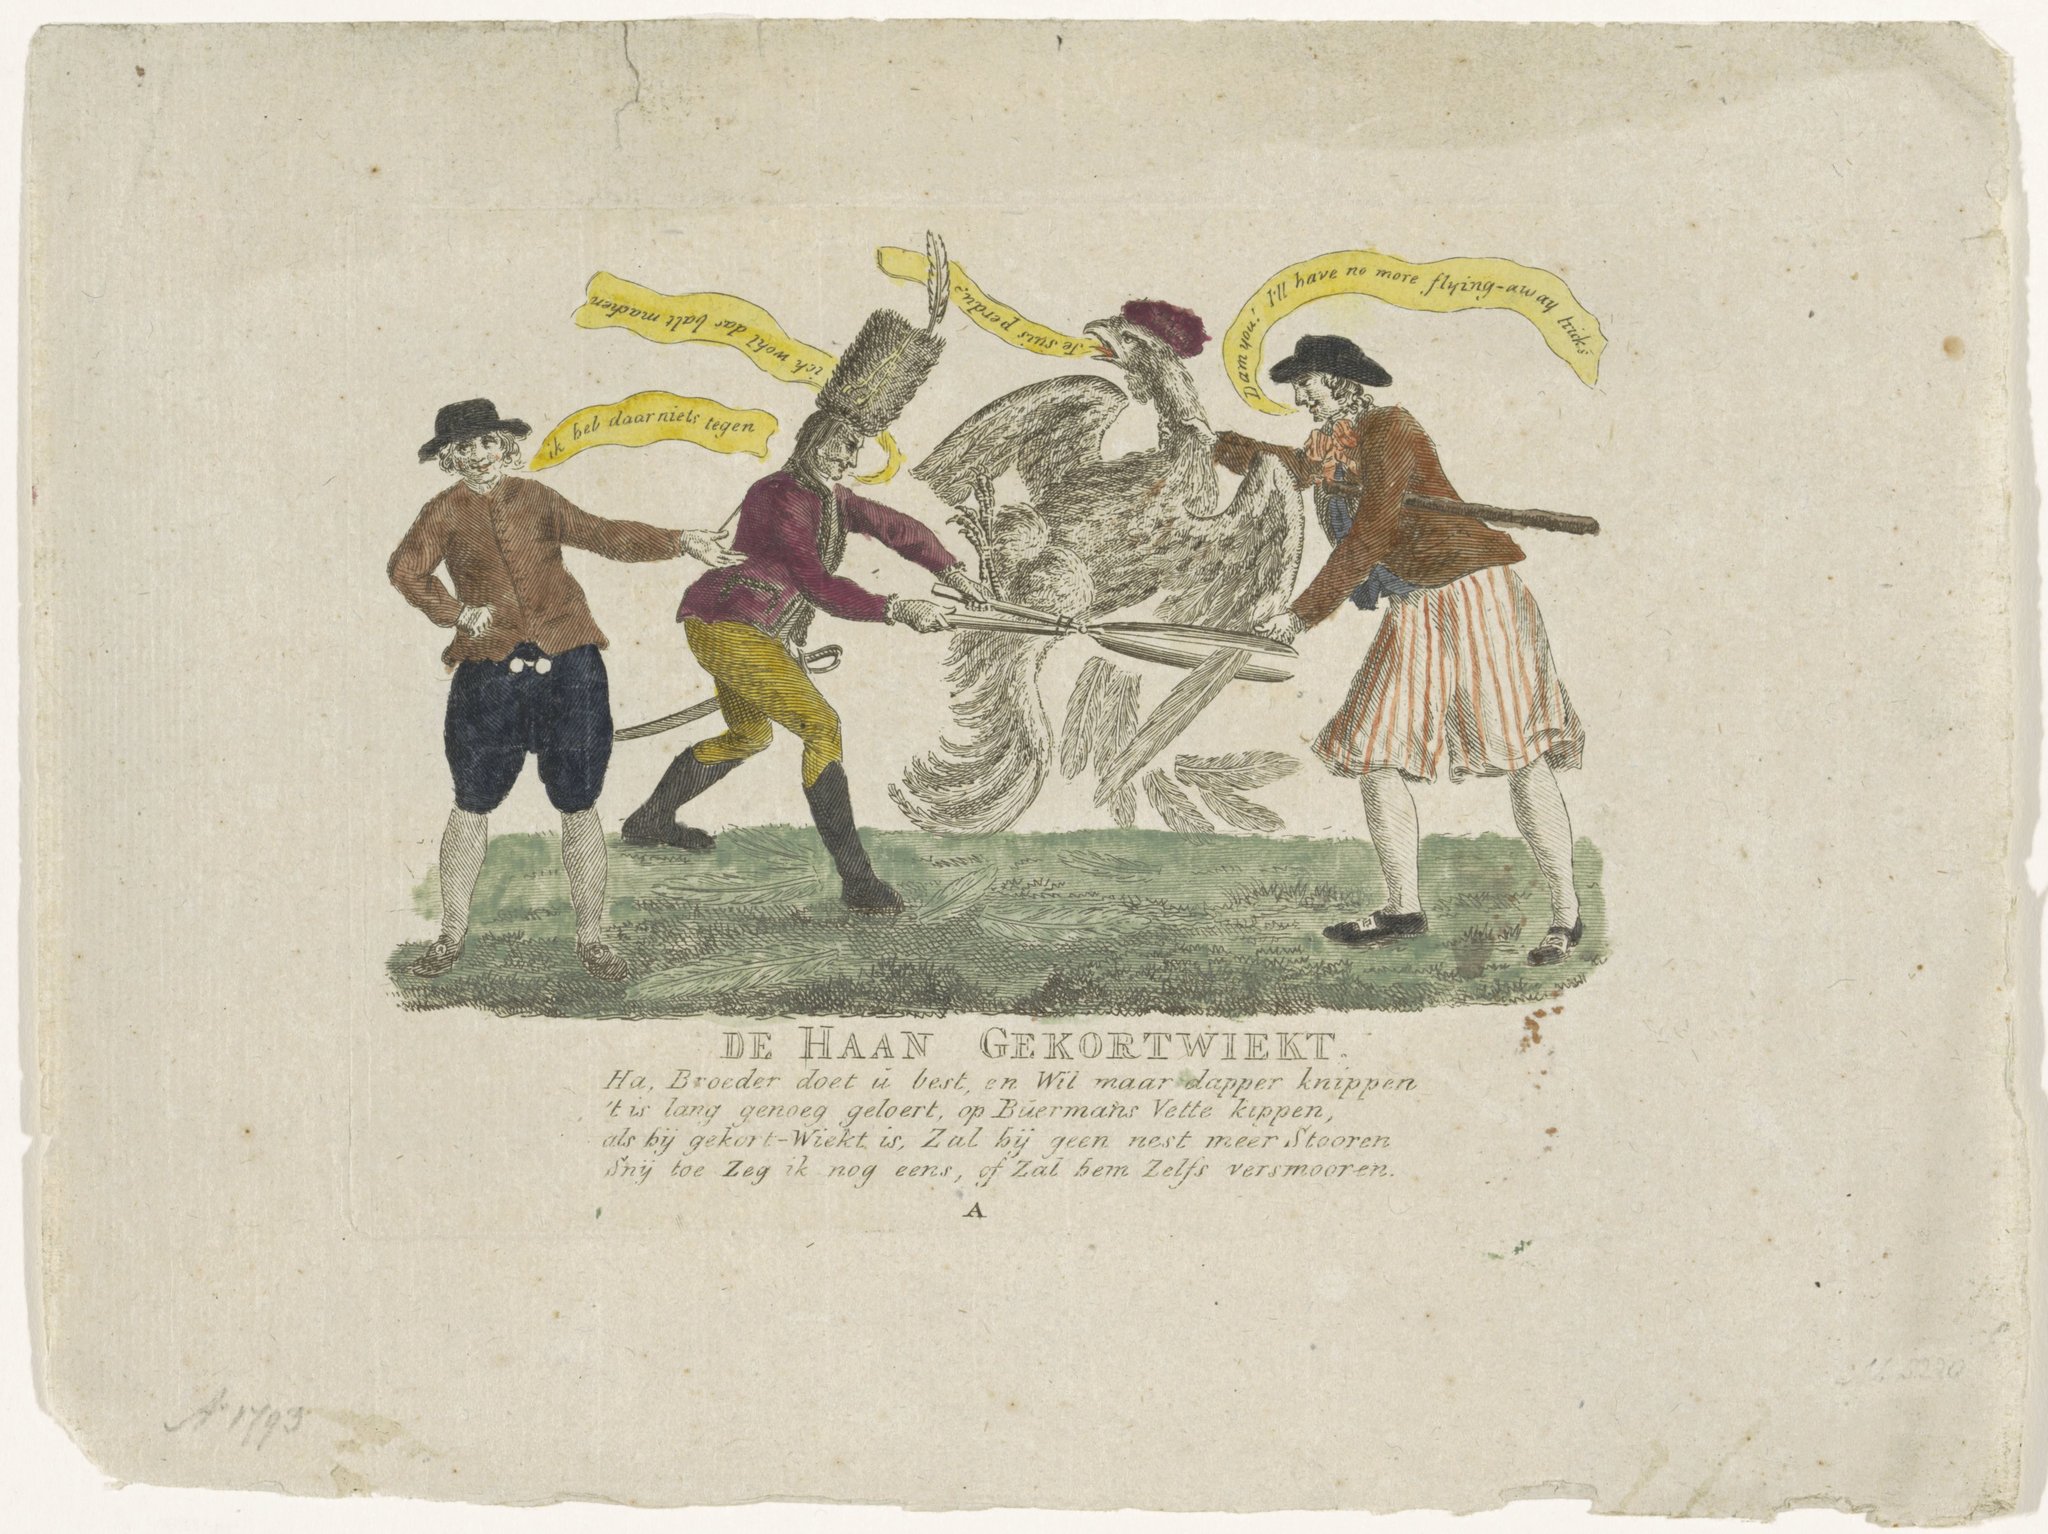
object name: cartoon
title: Kortwieken van de Franse haan, 1793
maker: Anonymous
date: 1793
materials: paper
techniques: engraving, etching, hand coloring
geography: northern netherlands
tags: clipping the wings of a bird, restraint of animals, netherlands, france, england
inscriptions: collector's mark: Lugt 2228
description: Een Engelsman houdt de Franse haan vast terwijl deze door de Pruisische soldaat wordt gekortwiekt. De Nederlander kijkt goedkeurend toe. In het onderschrift een vierregelig vers. Waarschijnlijk naar aanleiding van de Franse nederlaag bij Willemstad in 1793.